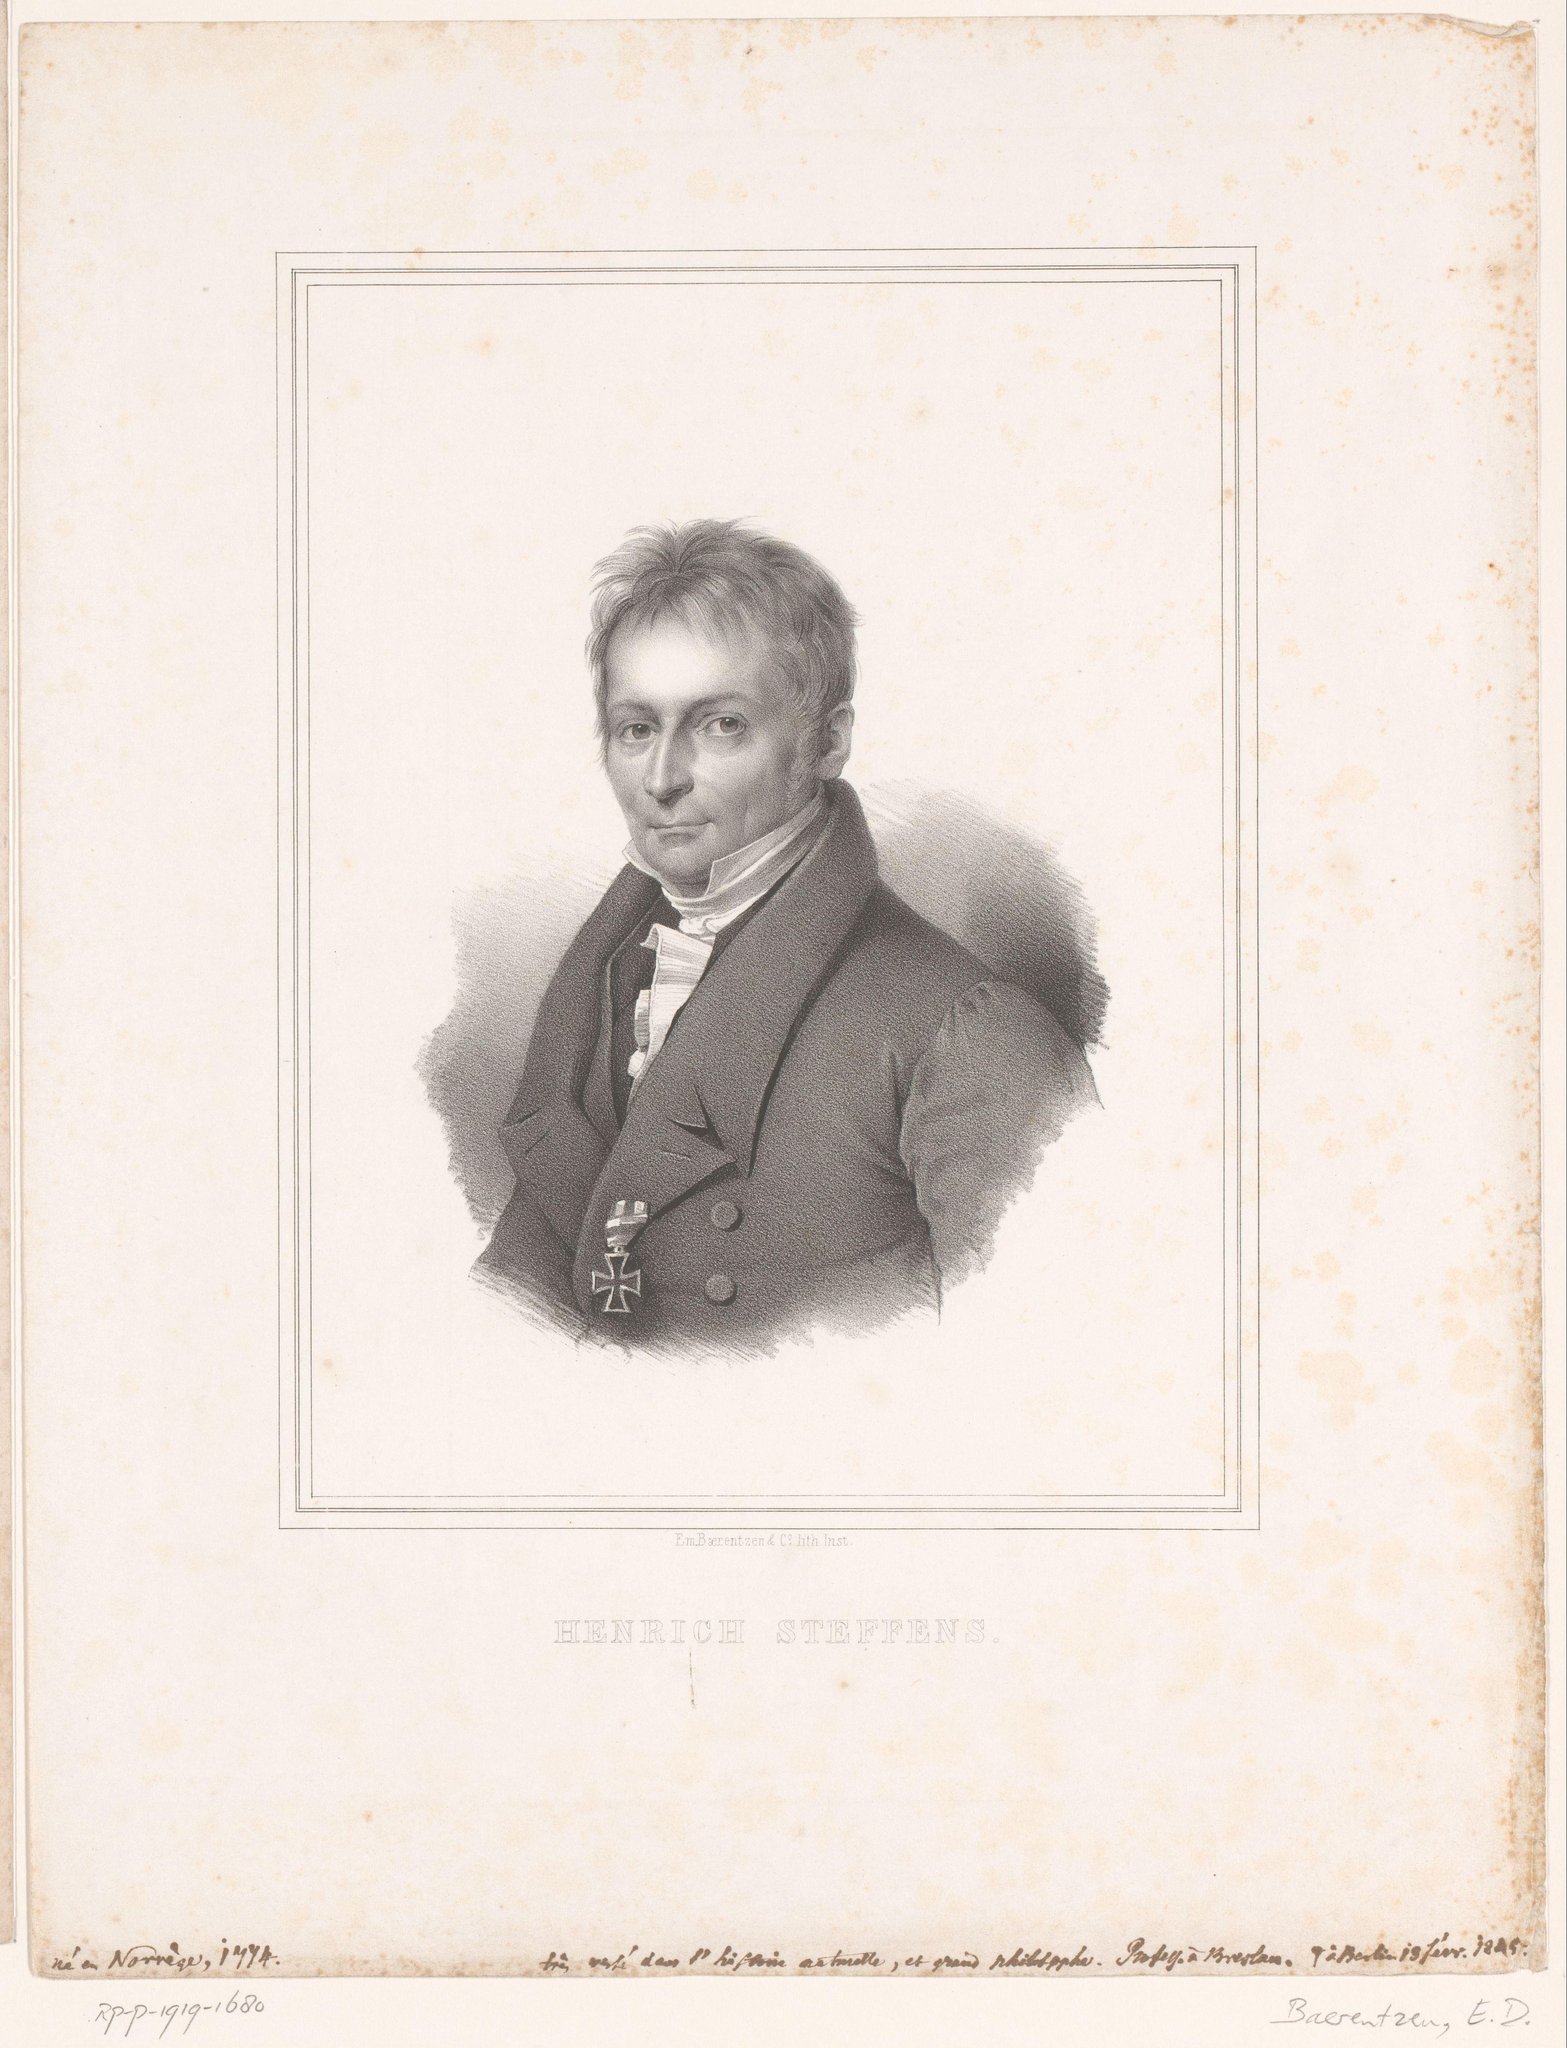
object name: print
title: Portret van Henrich Steffens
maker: emilius ditlev baerentzen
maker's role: print maker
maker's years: 1799-1868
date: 1837-1868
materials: paper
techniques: lithograph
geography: copenhagen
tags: berlin, historical persons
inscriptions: inscription: ‘Em. Baerentzen & Co lith.Inst.’, inscription: ‘Henrich Steffens.’, collector's mark: Lugt 2228